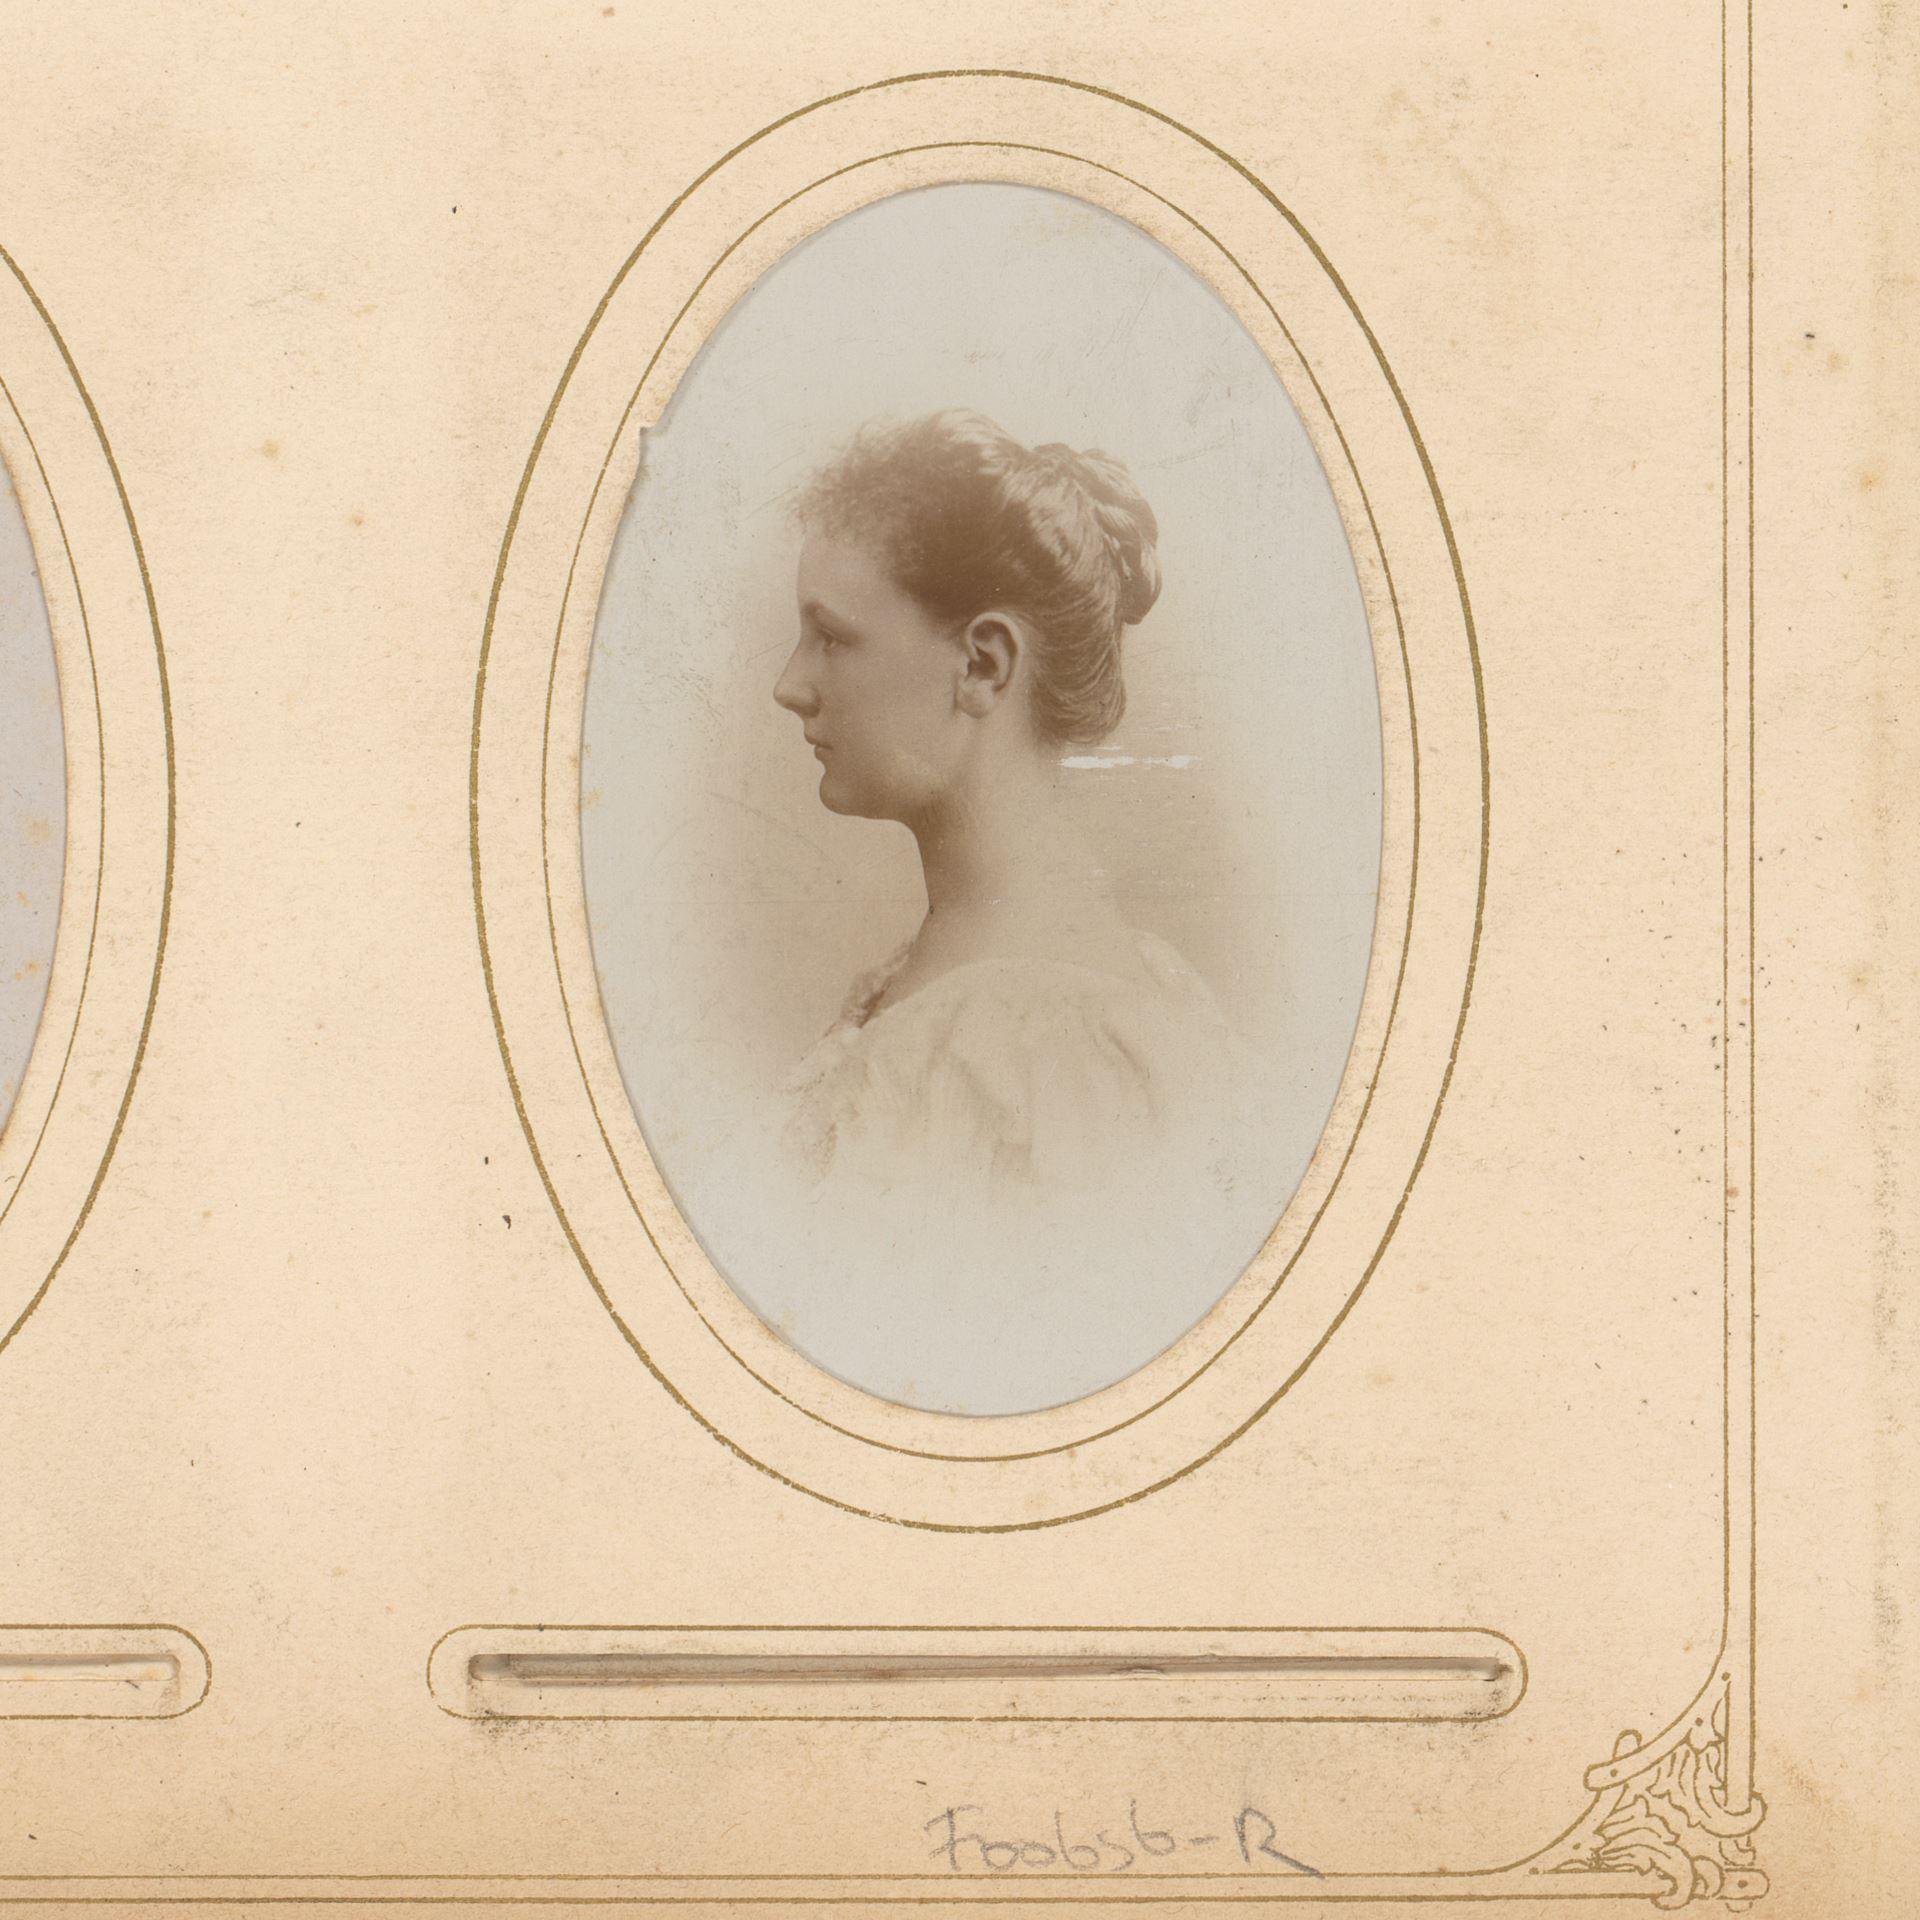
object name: photograph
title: Portret van koningin Wilhelmina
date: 1898-1900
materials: cardboard, photographic support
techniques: collodion silver print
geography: the hague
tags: the hague, print maker, wilhelmina of the netherlands, historical persons - bb - woman, queen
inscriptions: inscription: ‘B. v. d. Heuvel & Co den Haag./ korte houtstraat 31a’